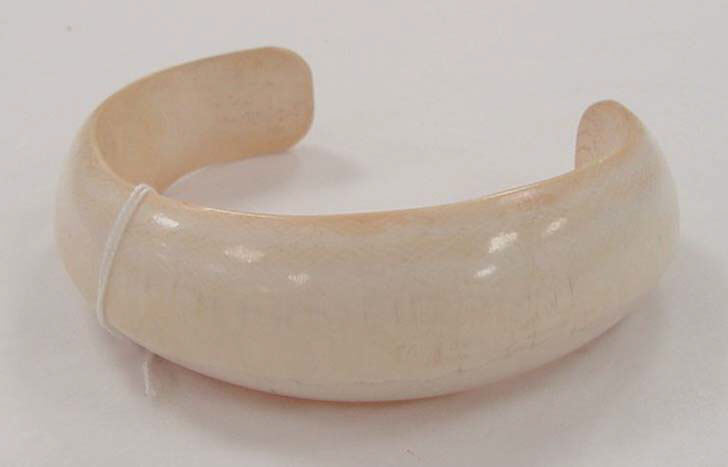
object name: necklace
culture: african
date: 1801-1900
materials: ivory